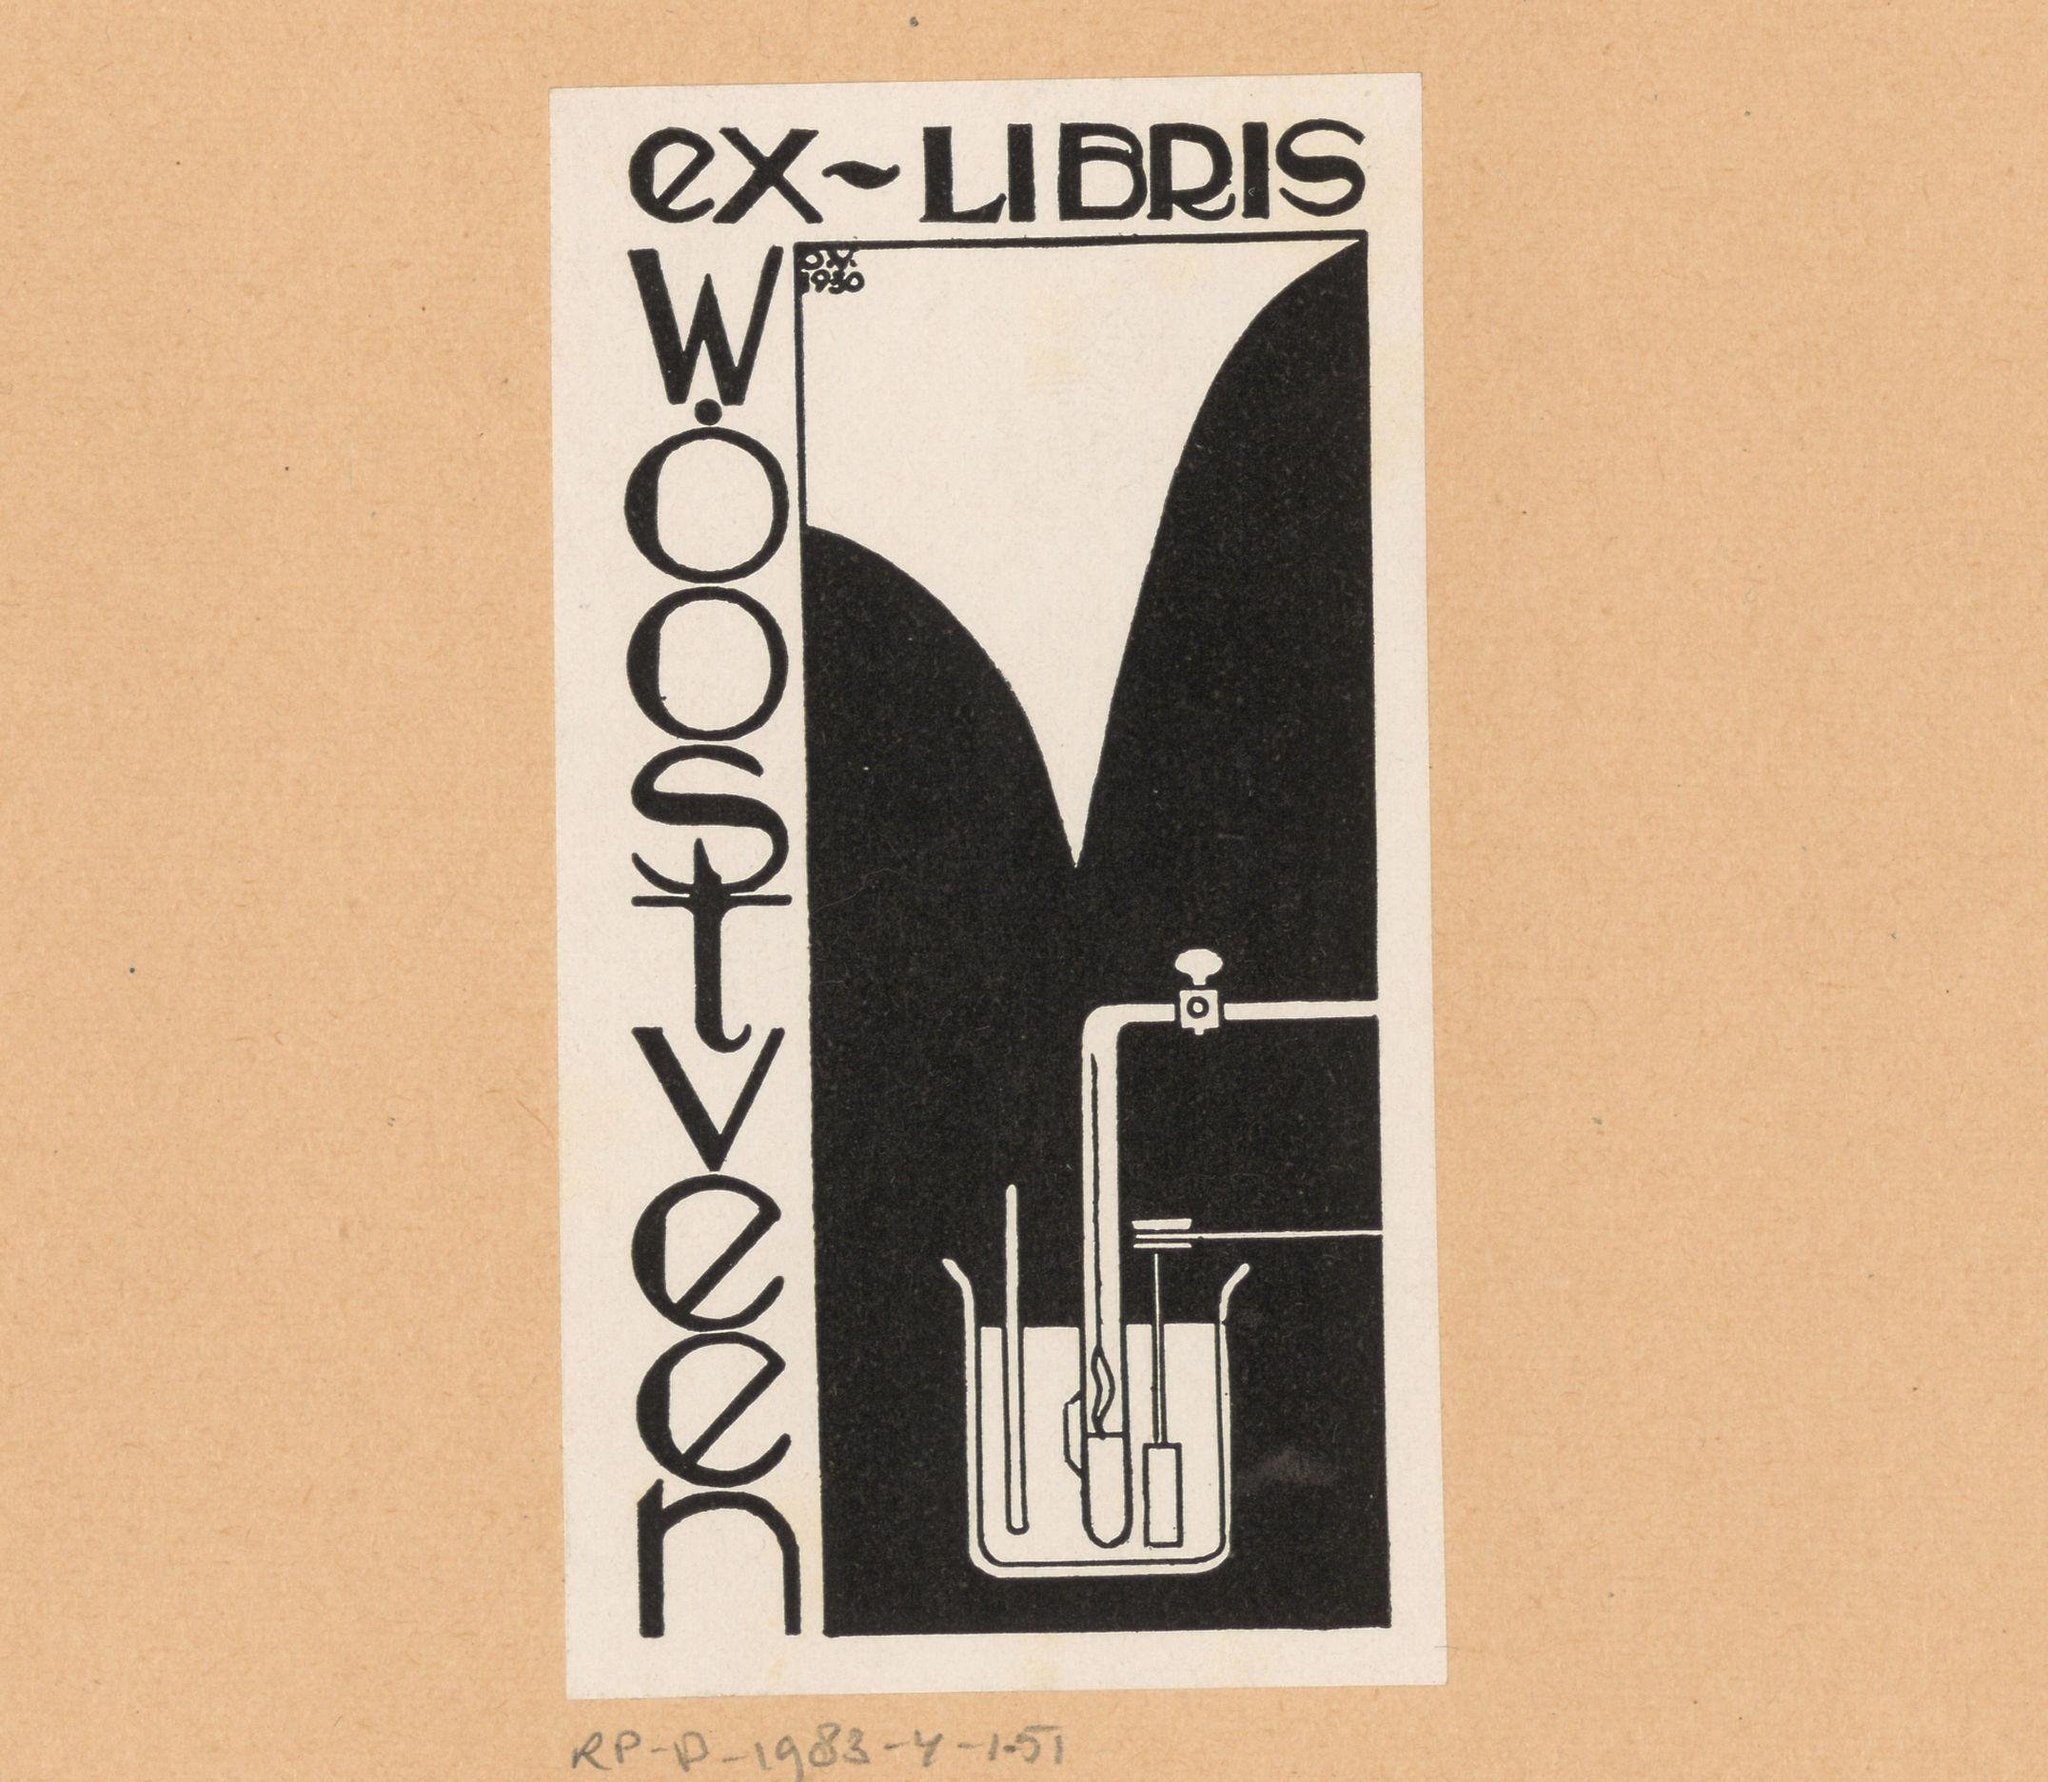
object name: bookplate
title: Ex libris van W. Oostveen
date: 1930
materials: paper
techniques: printing block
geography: netherlands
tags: chemistry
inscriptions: inscription: ‘Clichédruk - Jaar 1930. (...) 1931 Los Angeles.’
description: Verbeeld wordt een smeltpuntdiagram van een mengsel van twee stoffen en een apparaat dat metingen doet. Ontwerp werd door Verhagen ingezonden voor de 7th Annual ex libris exhibition van The Bookplate Association International, mei 1931 in Los Angeles.